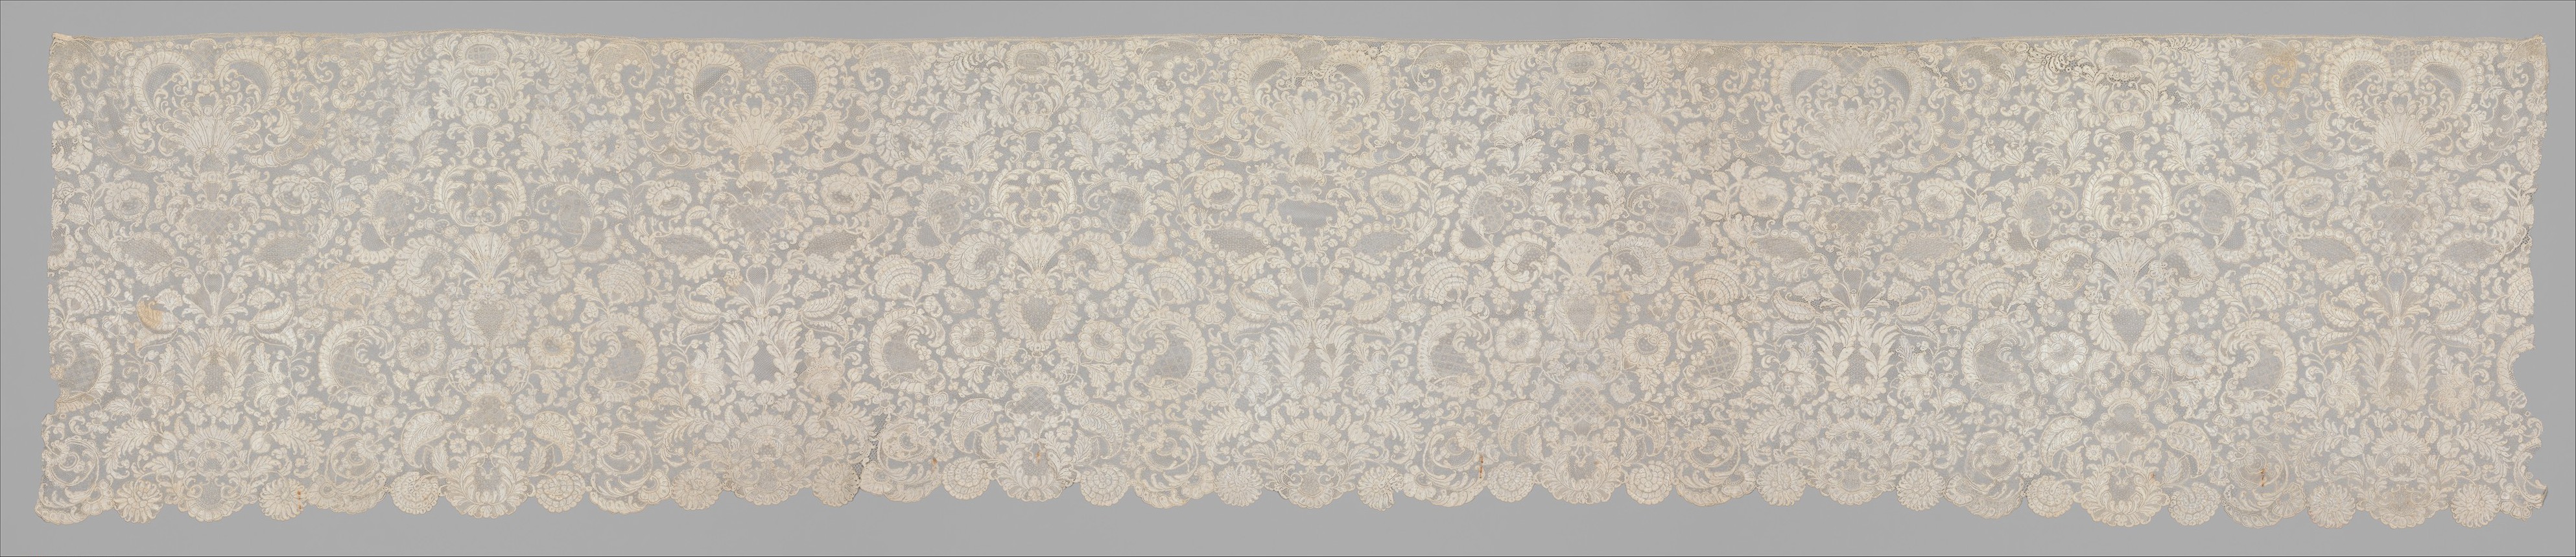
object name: flounce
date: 1701-1750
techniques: lace